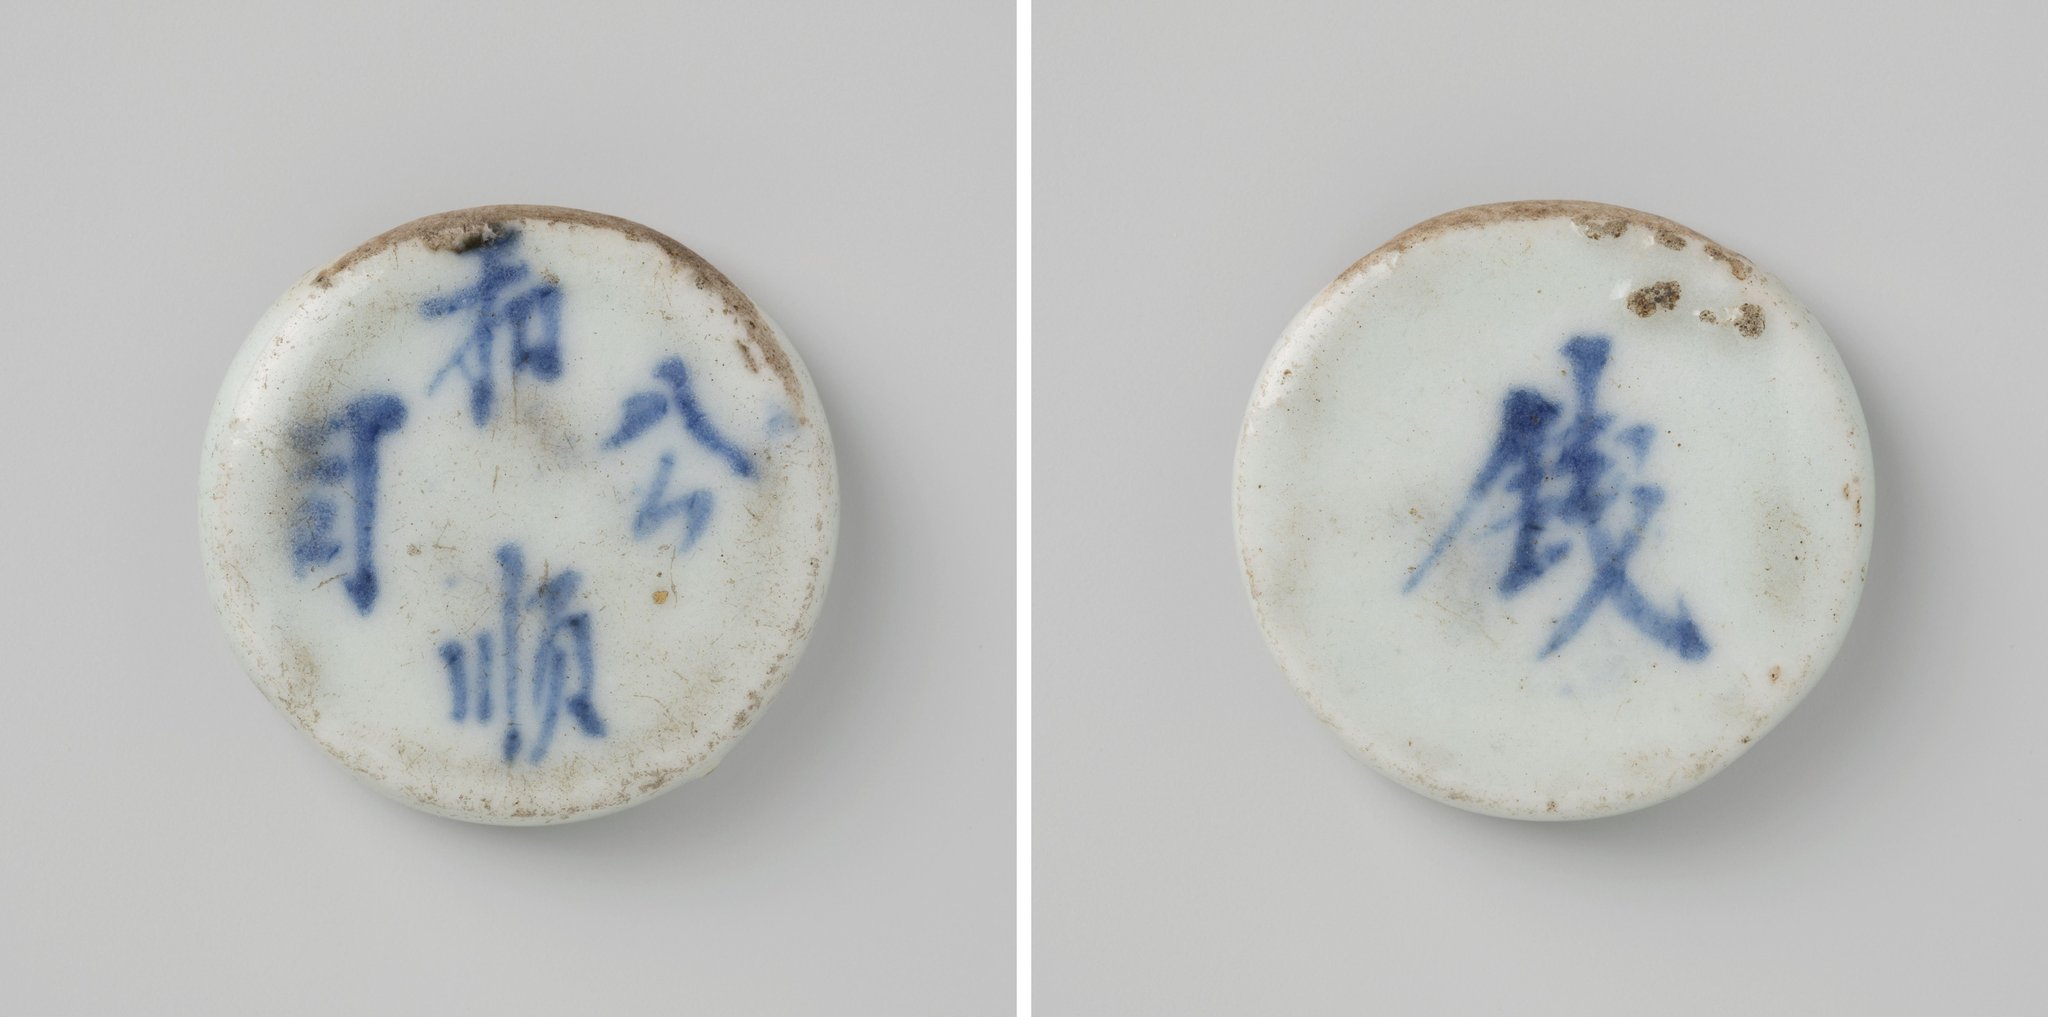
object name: coin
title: Speelhuispenning uit Thailand ter waarde van een salung, 1760-1871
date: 1760-1871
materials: porcelain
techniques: firing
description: Ronde porseleinen speelhuispenning, die ook als munt is gebruikt. Voorzijde: vier Chinese karakters. Keerzijde: een Chinees karakter.